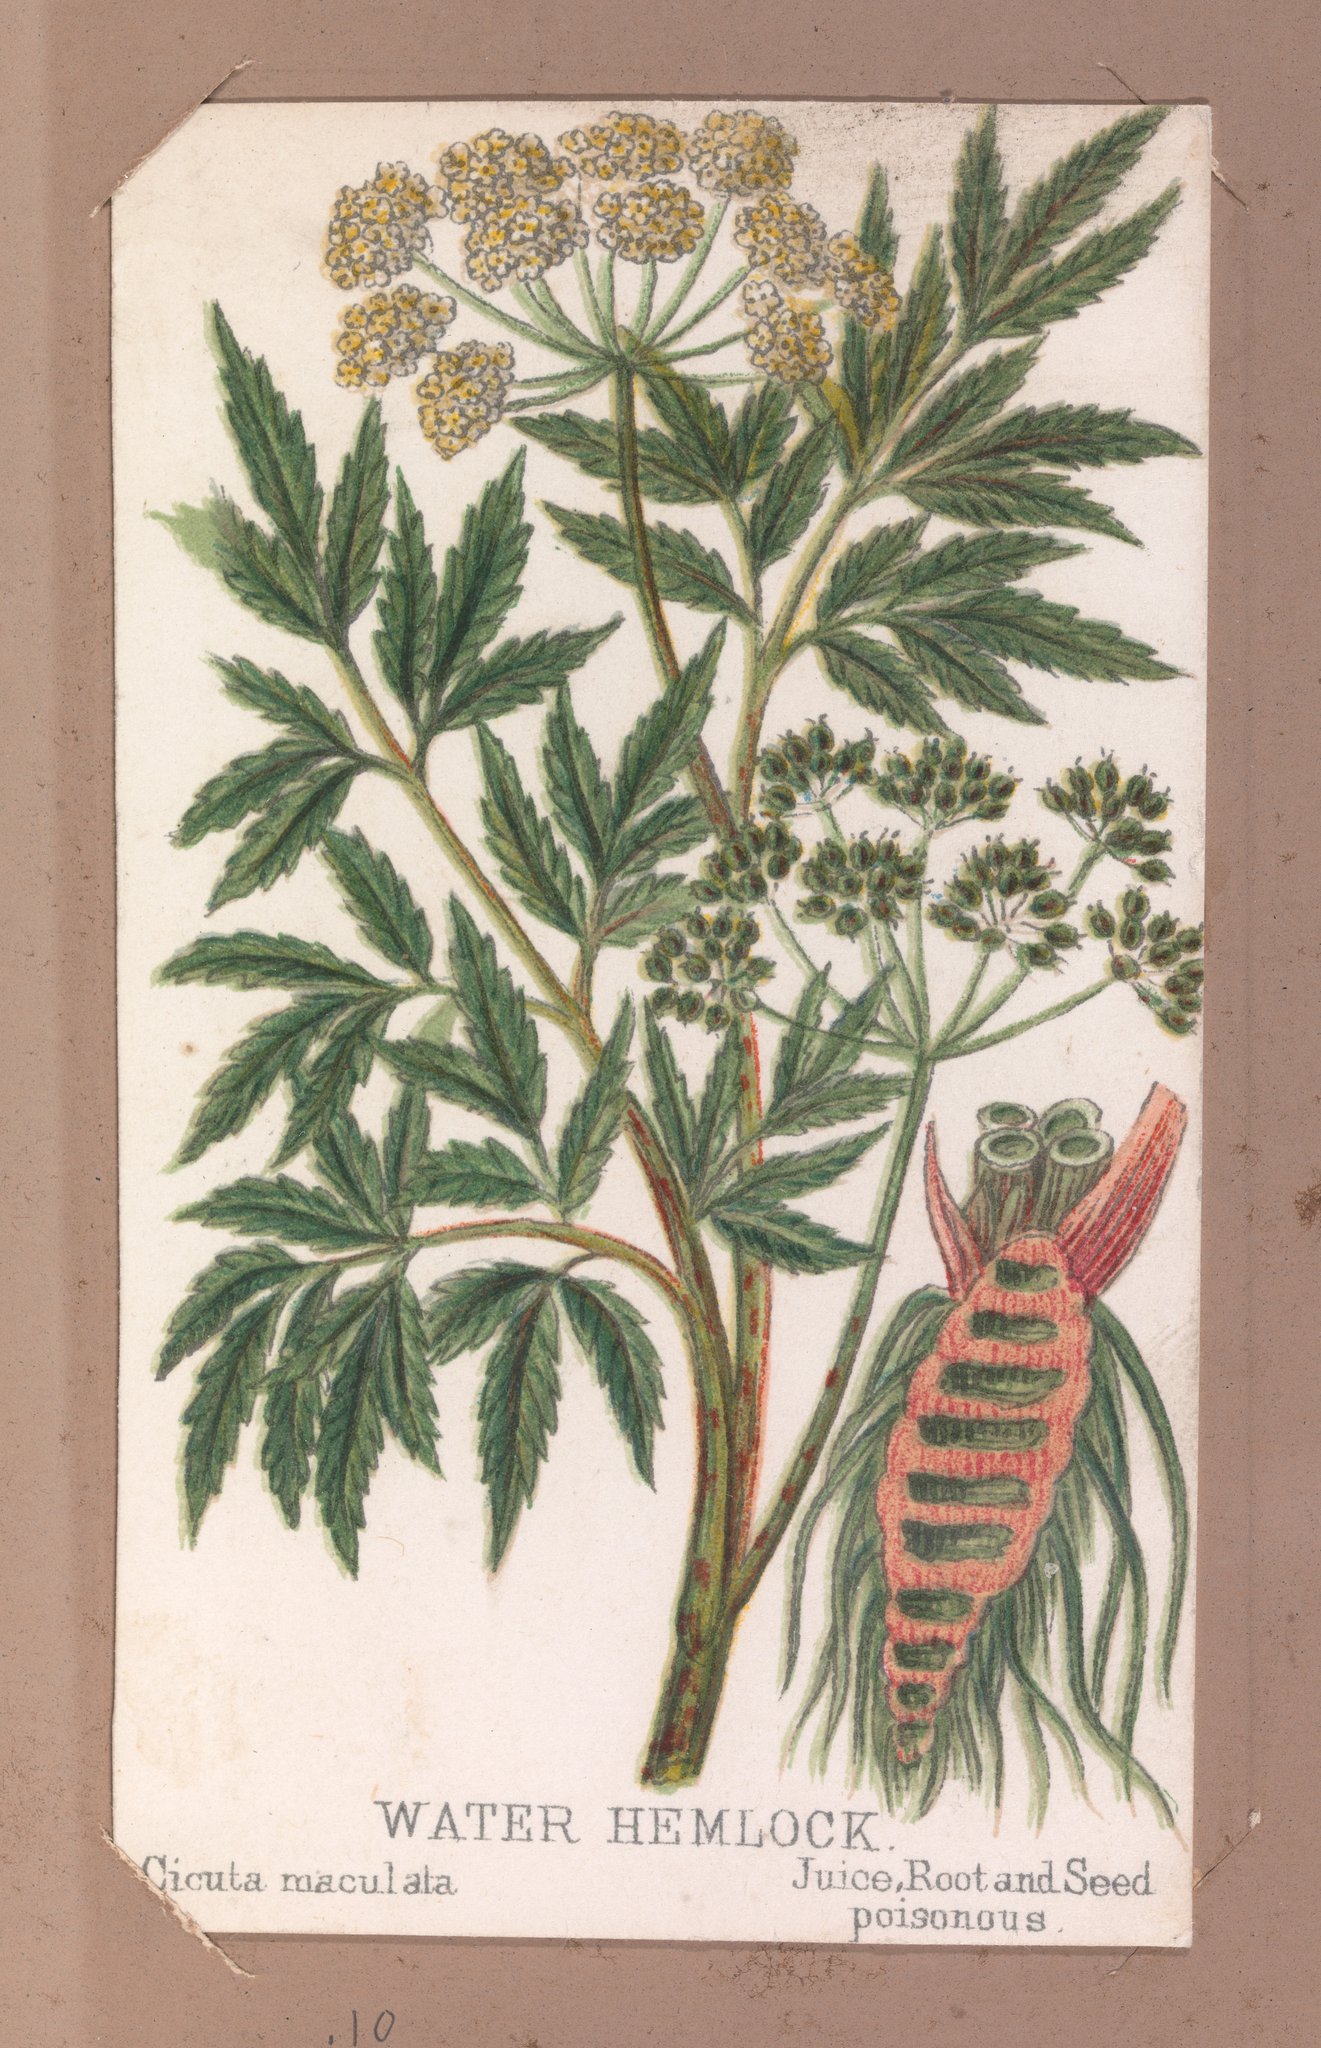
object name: album card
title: Water Hemlock from the Plants series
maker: louis prang & co.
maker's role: publisher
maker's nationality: american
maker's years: 1800-1950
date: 1862-1869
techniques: lithograph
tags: plants